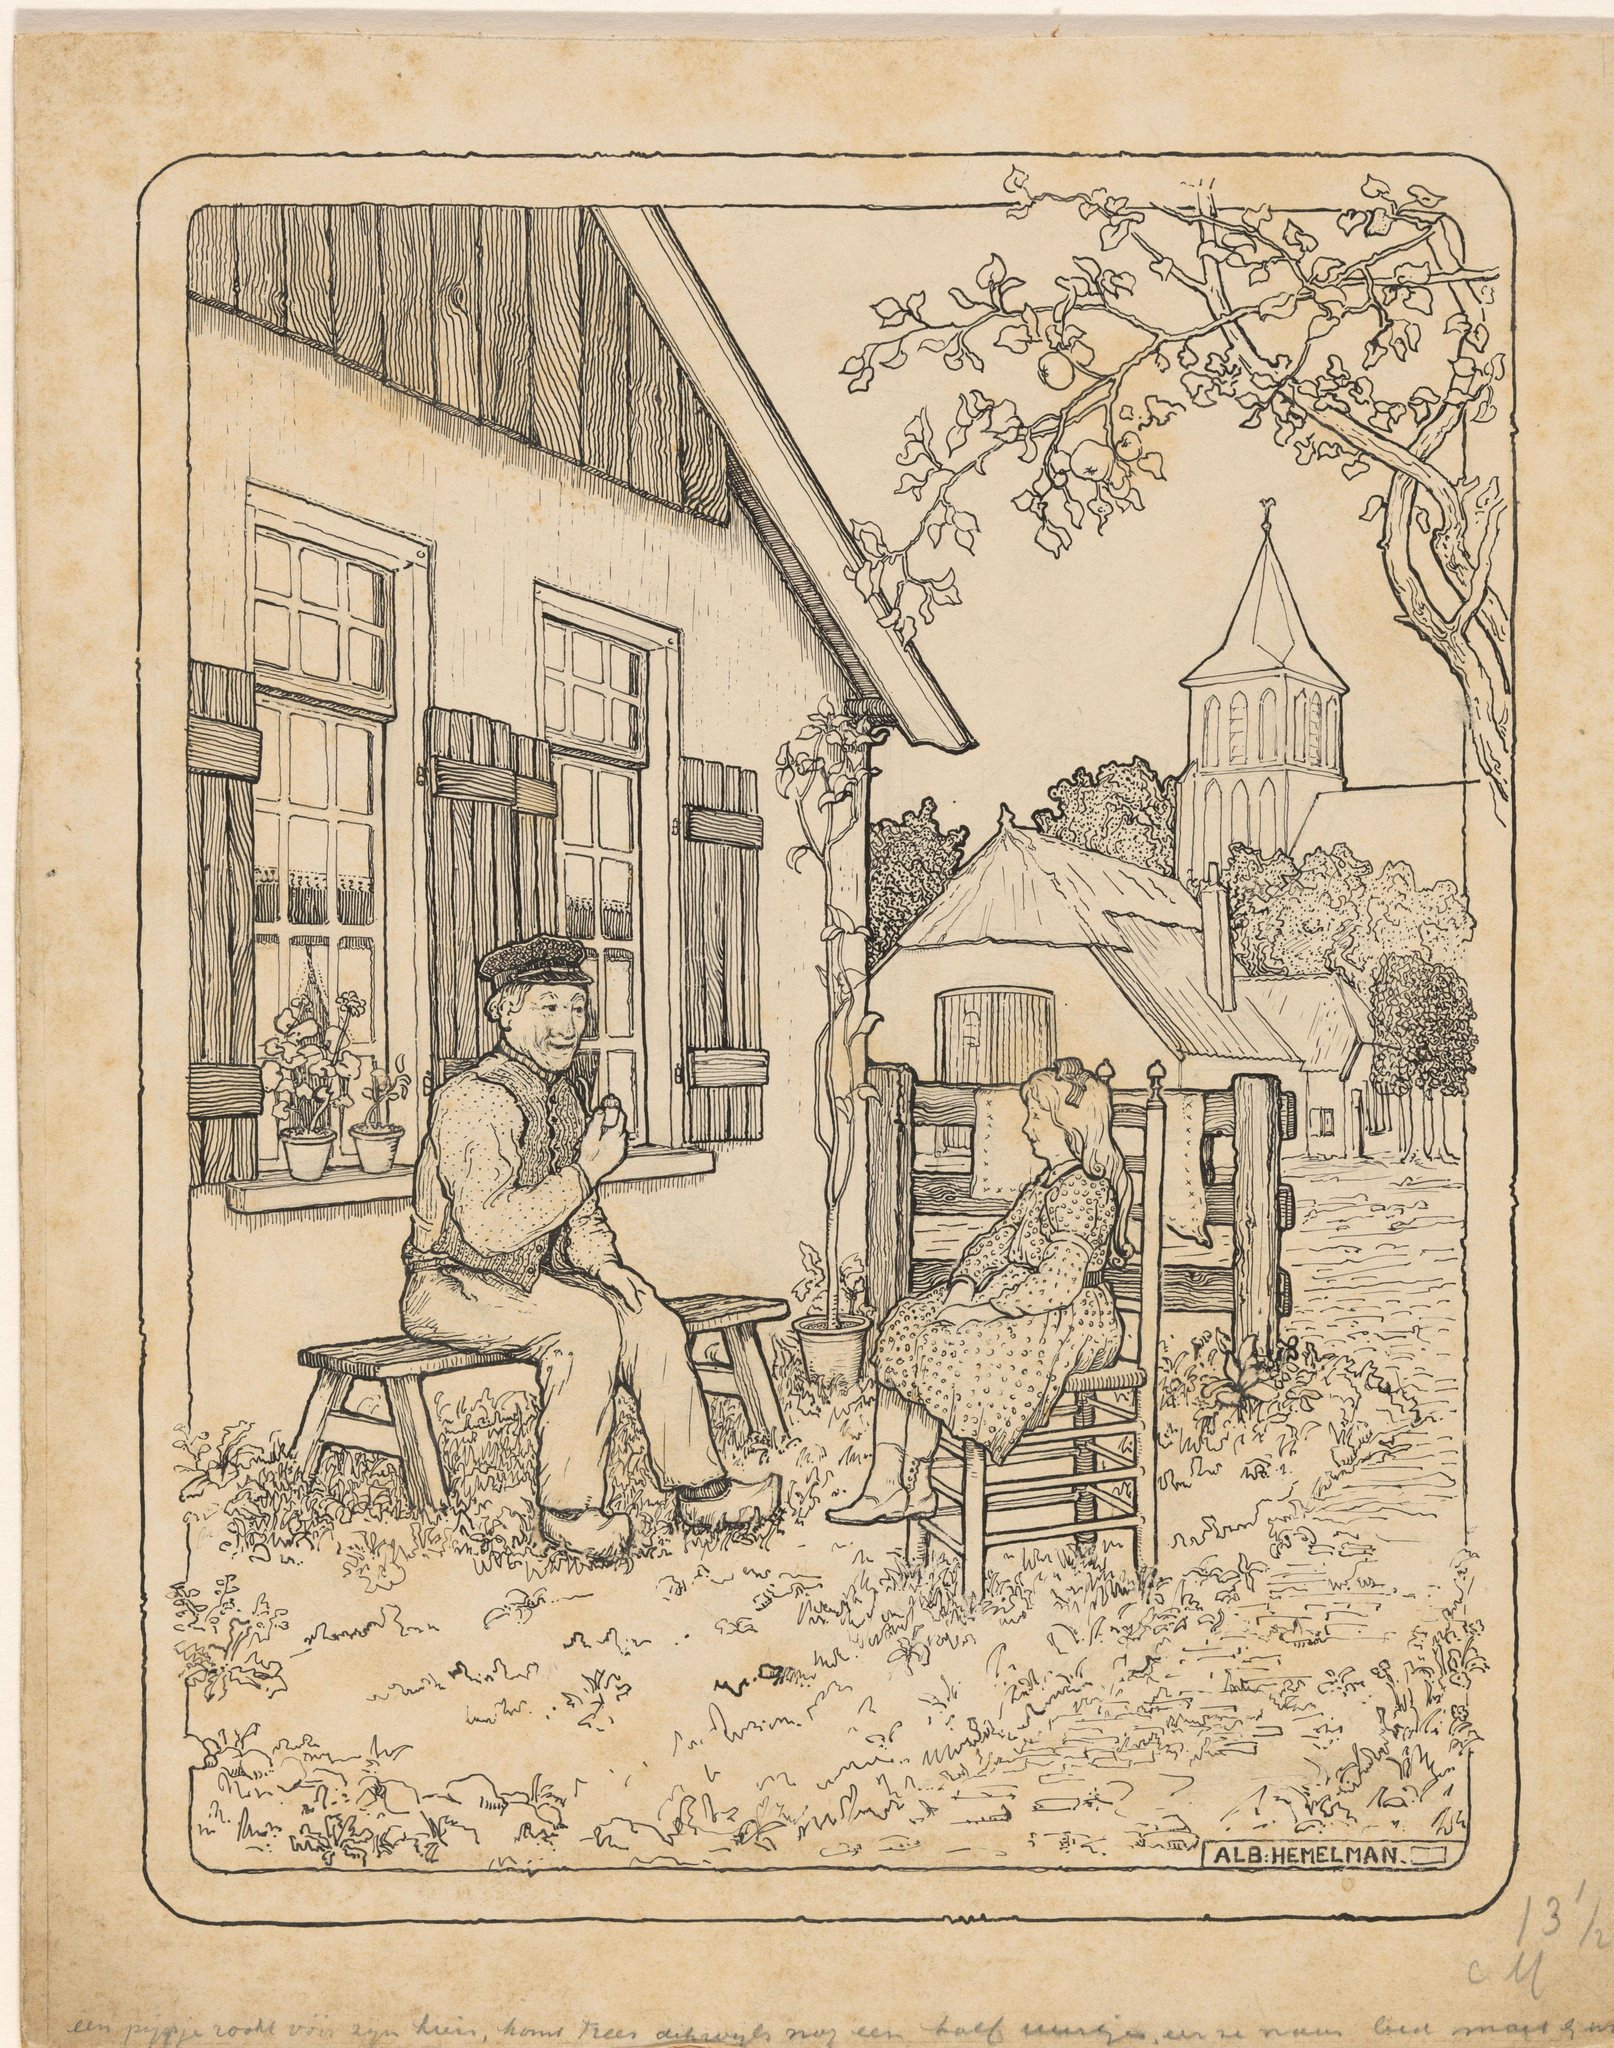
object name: drawing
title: Pijprokende Dakhuis zittend voor zijn huis met Trees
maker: albert hemelman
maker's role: draughtsman, print maker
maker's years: 1883-1951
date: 1893-1951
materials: cardboard, ink, pencil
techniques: pen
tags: garden, pipe ~ tobacco, rural housing, e.g. country-house, villa, cottage, girl (child between toddler and youth)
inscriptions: collector's mark: Lugt 2228, signature: ‘ALB:HEMELMAN.’, :, annotation: ‘een pijpje rookt vóór zijn huis, komt Trees dikwijls nog een half uurtje, eer ze naar bed moet enz’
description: Voor een plattelandswoning met luiken zit Dakhuis een pijp te roken op een bank. Schuin tegenover hem zit Trees op een stoel. Op de achtergrond een huis met rieten dak en een kerk.